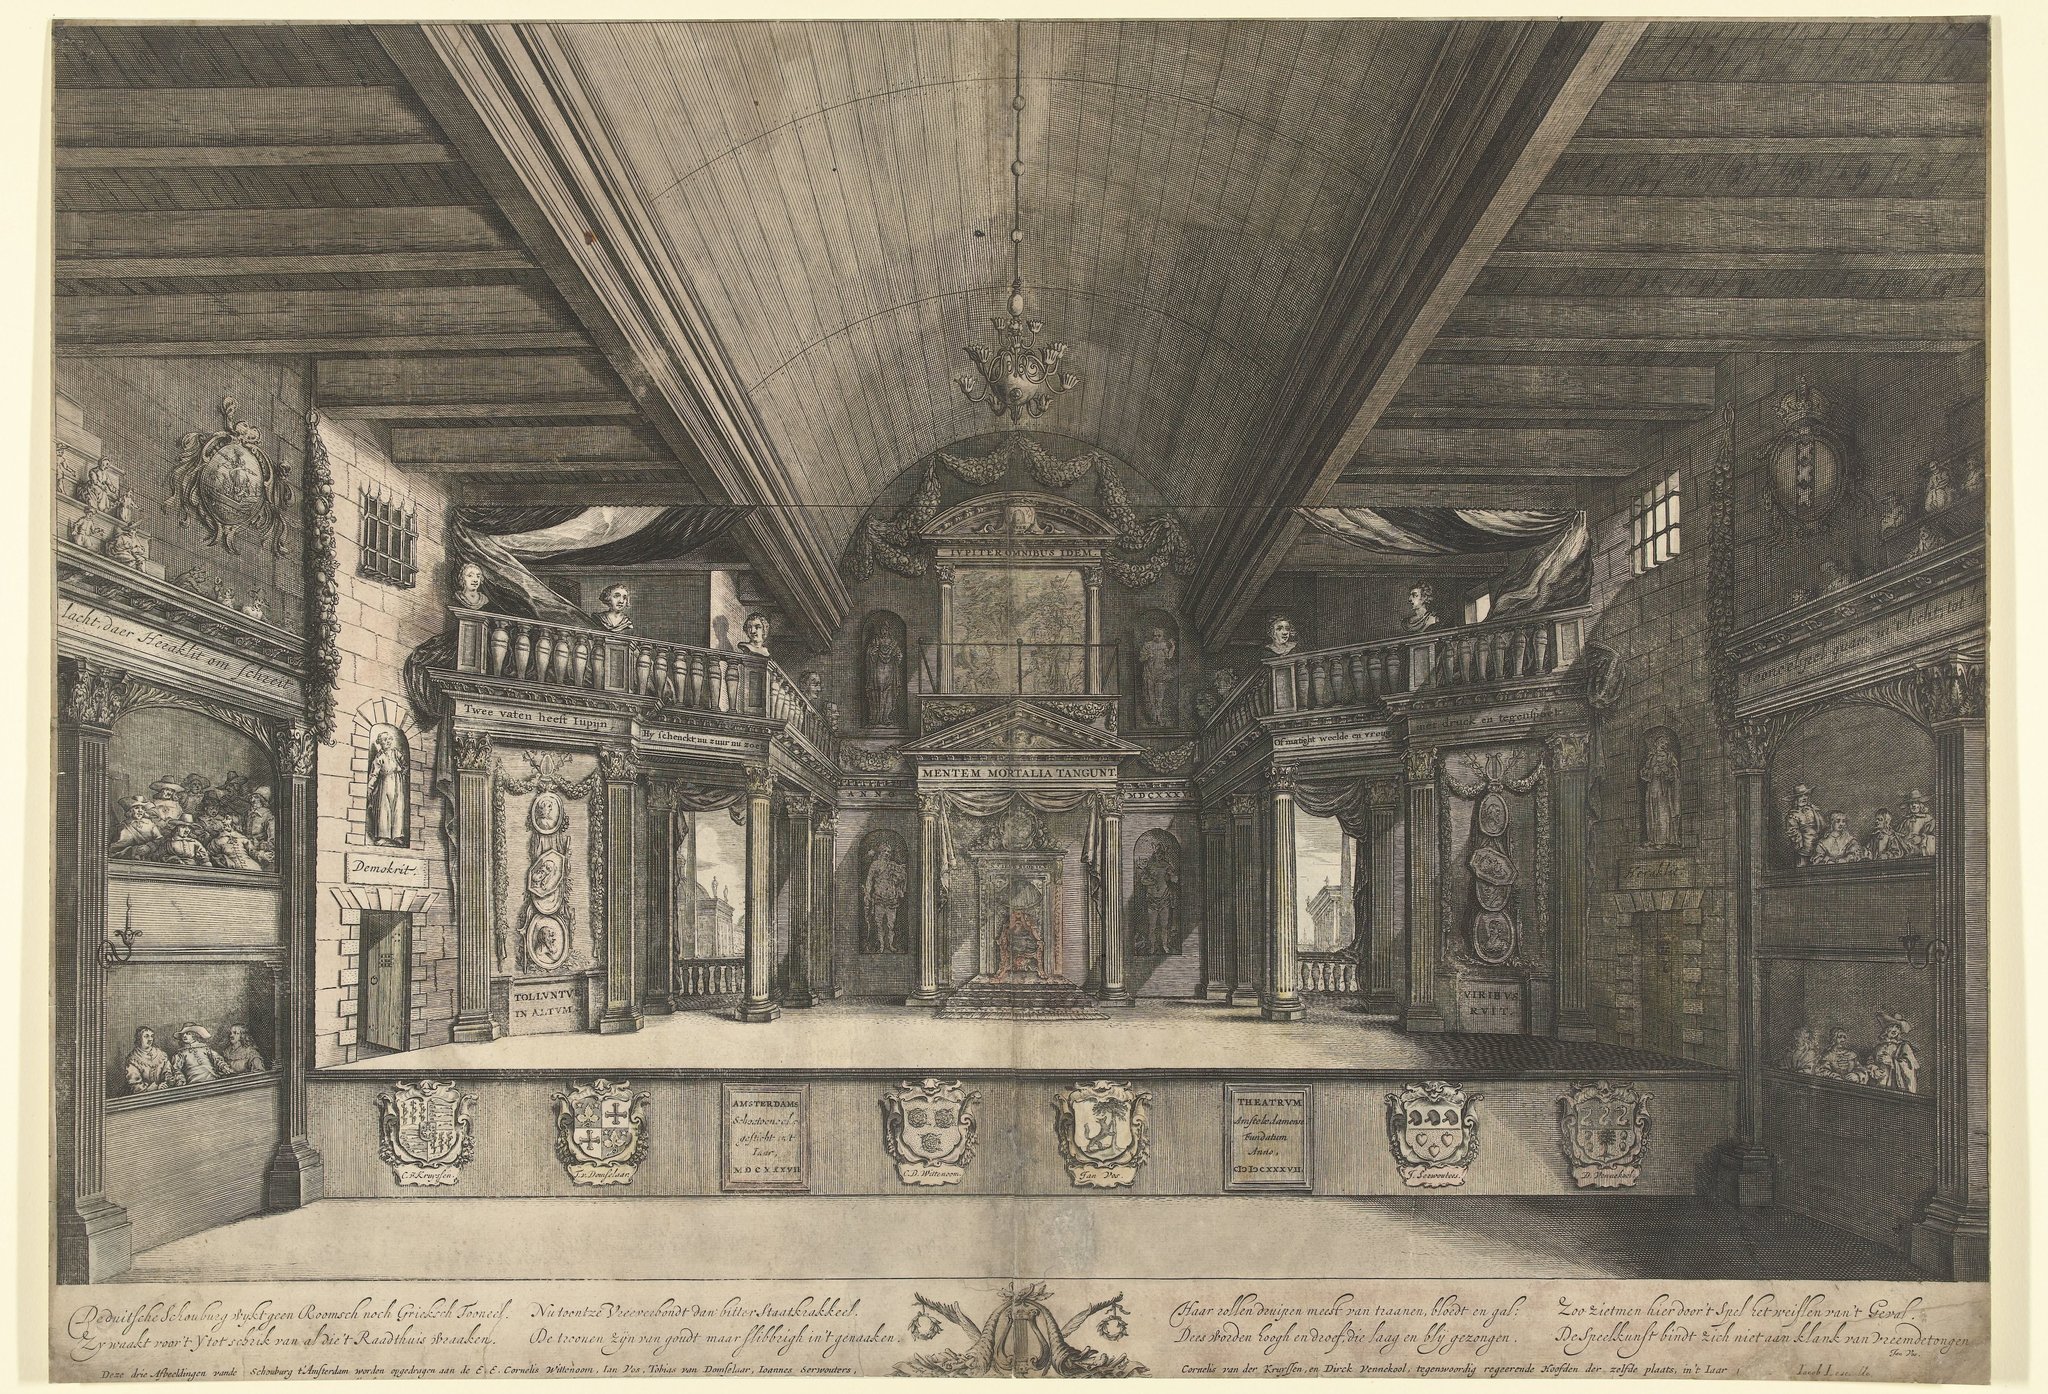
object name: print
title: Amsterdams Schoutooneel gesticht in 't Iaer MDCXXXVII / Theatrum Amstelaedamense Fundatum Anno, MDCXXXVII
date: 1658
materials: paper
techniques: engraving, hand coloring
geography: northern netherlands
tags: the stage and its equipment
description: Gezicht op het toneel van de nieuwe stadsschouwburg op de Keizersgracht 384 te Amsterdam, 1637. In de loges links en rechts zitten toeschouwers. Aan de onderkant van het toneel staan zes wapenschilden van de hoofden van de Schouwburg. In het onderschrift 4 keer 2 regels in het Nederlands.